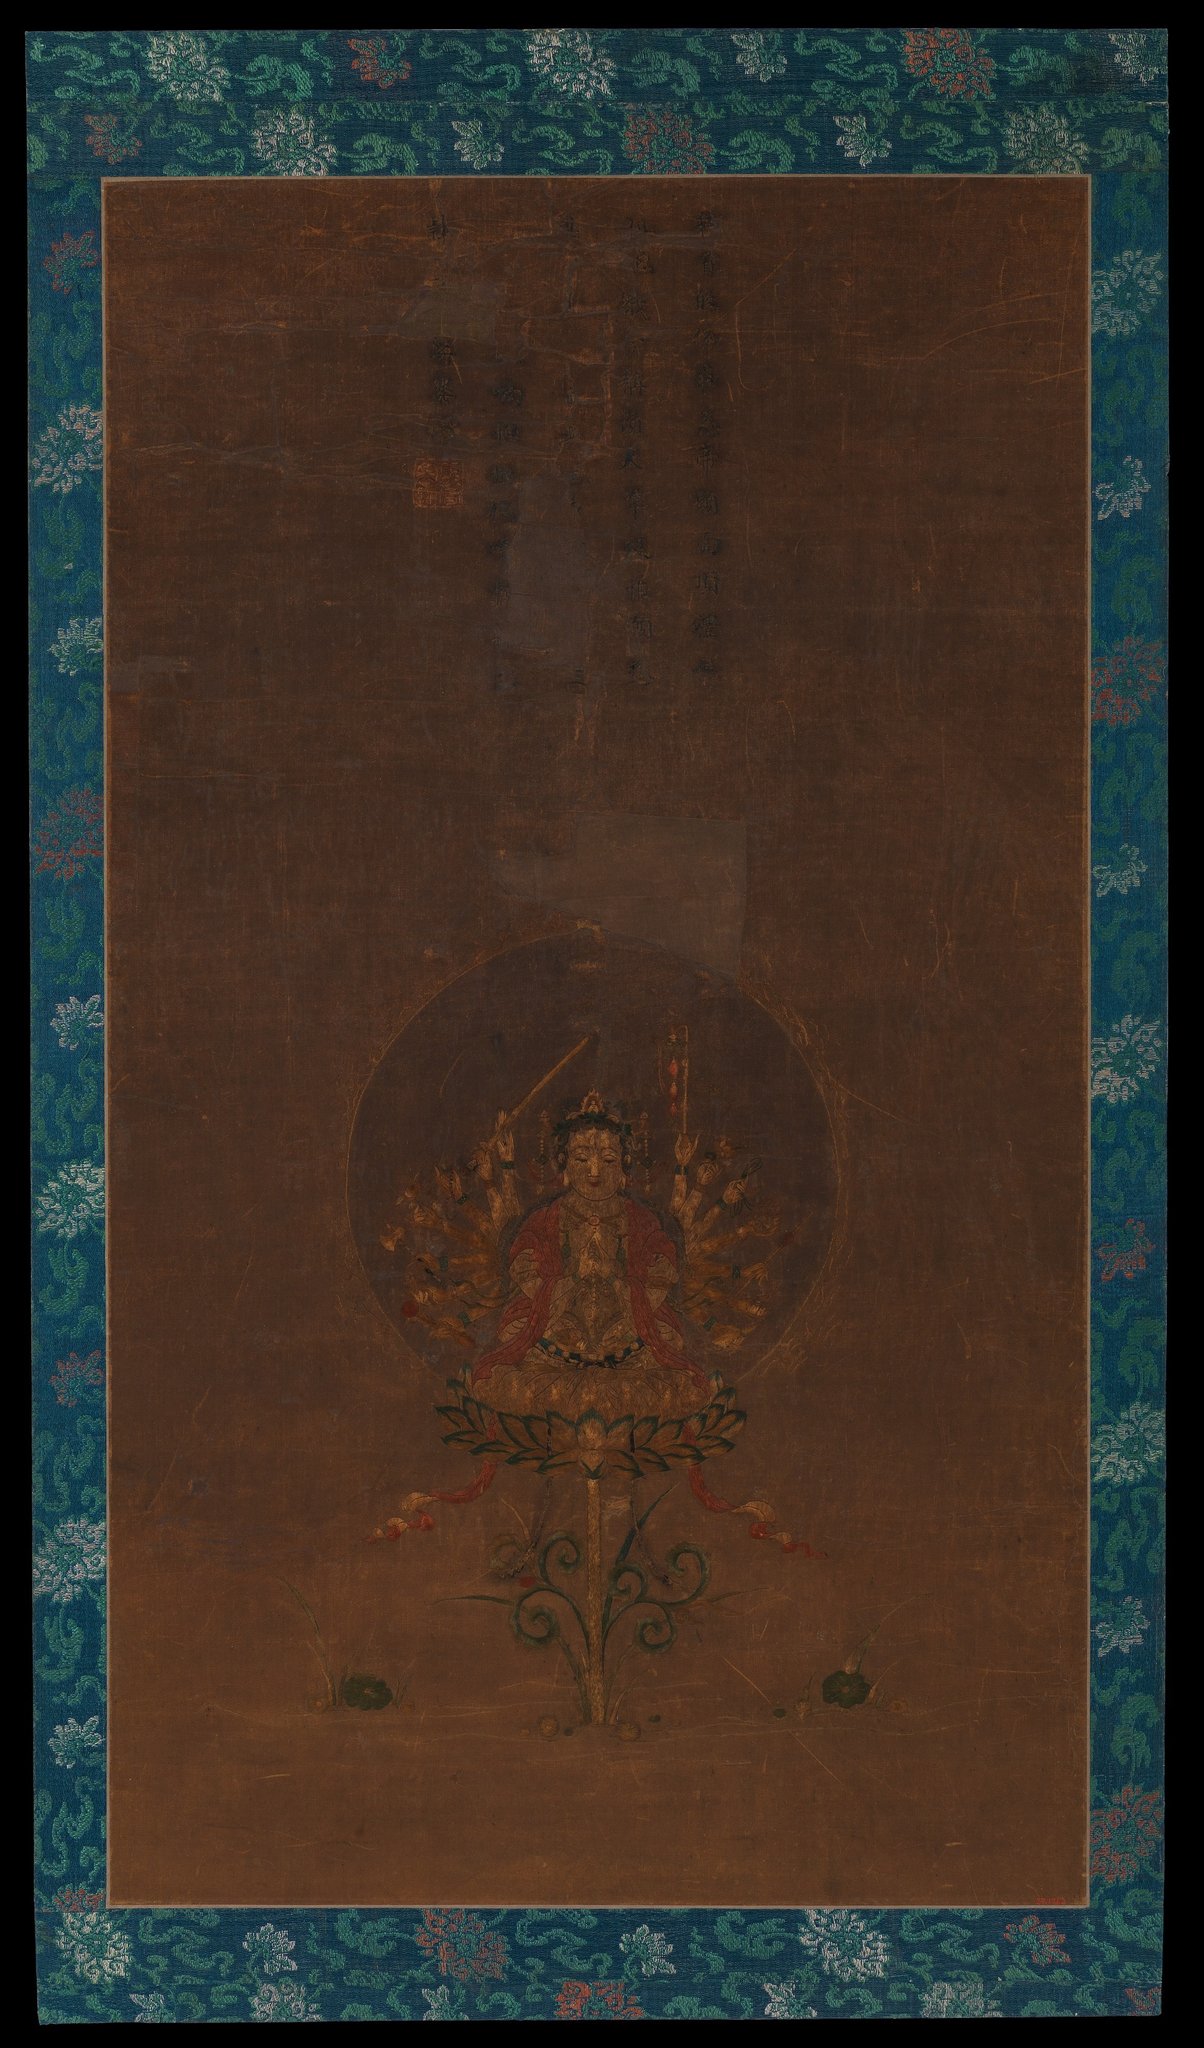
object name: textile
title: Thousand-armed Guanyin seated on lotus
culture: chinese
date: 1501-1600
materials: silk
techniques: embroidery